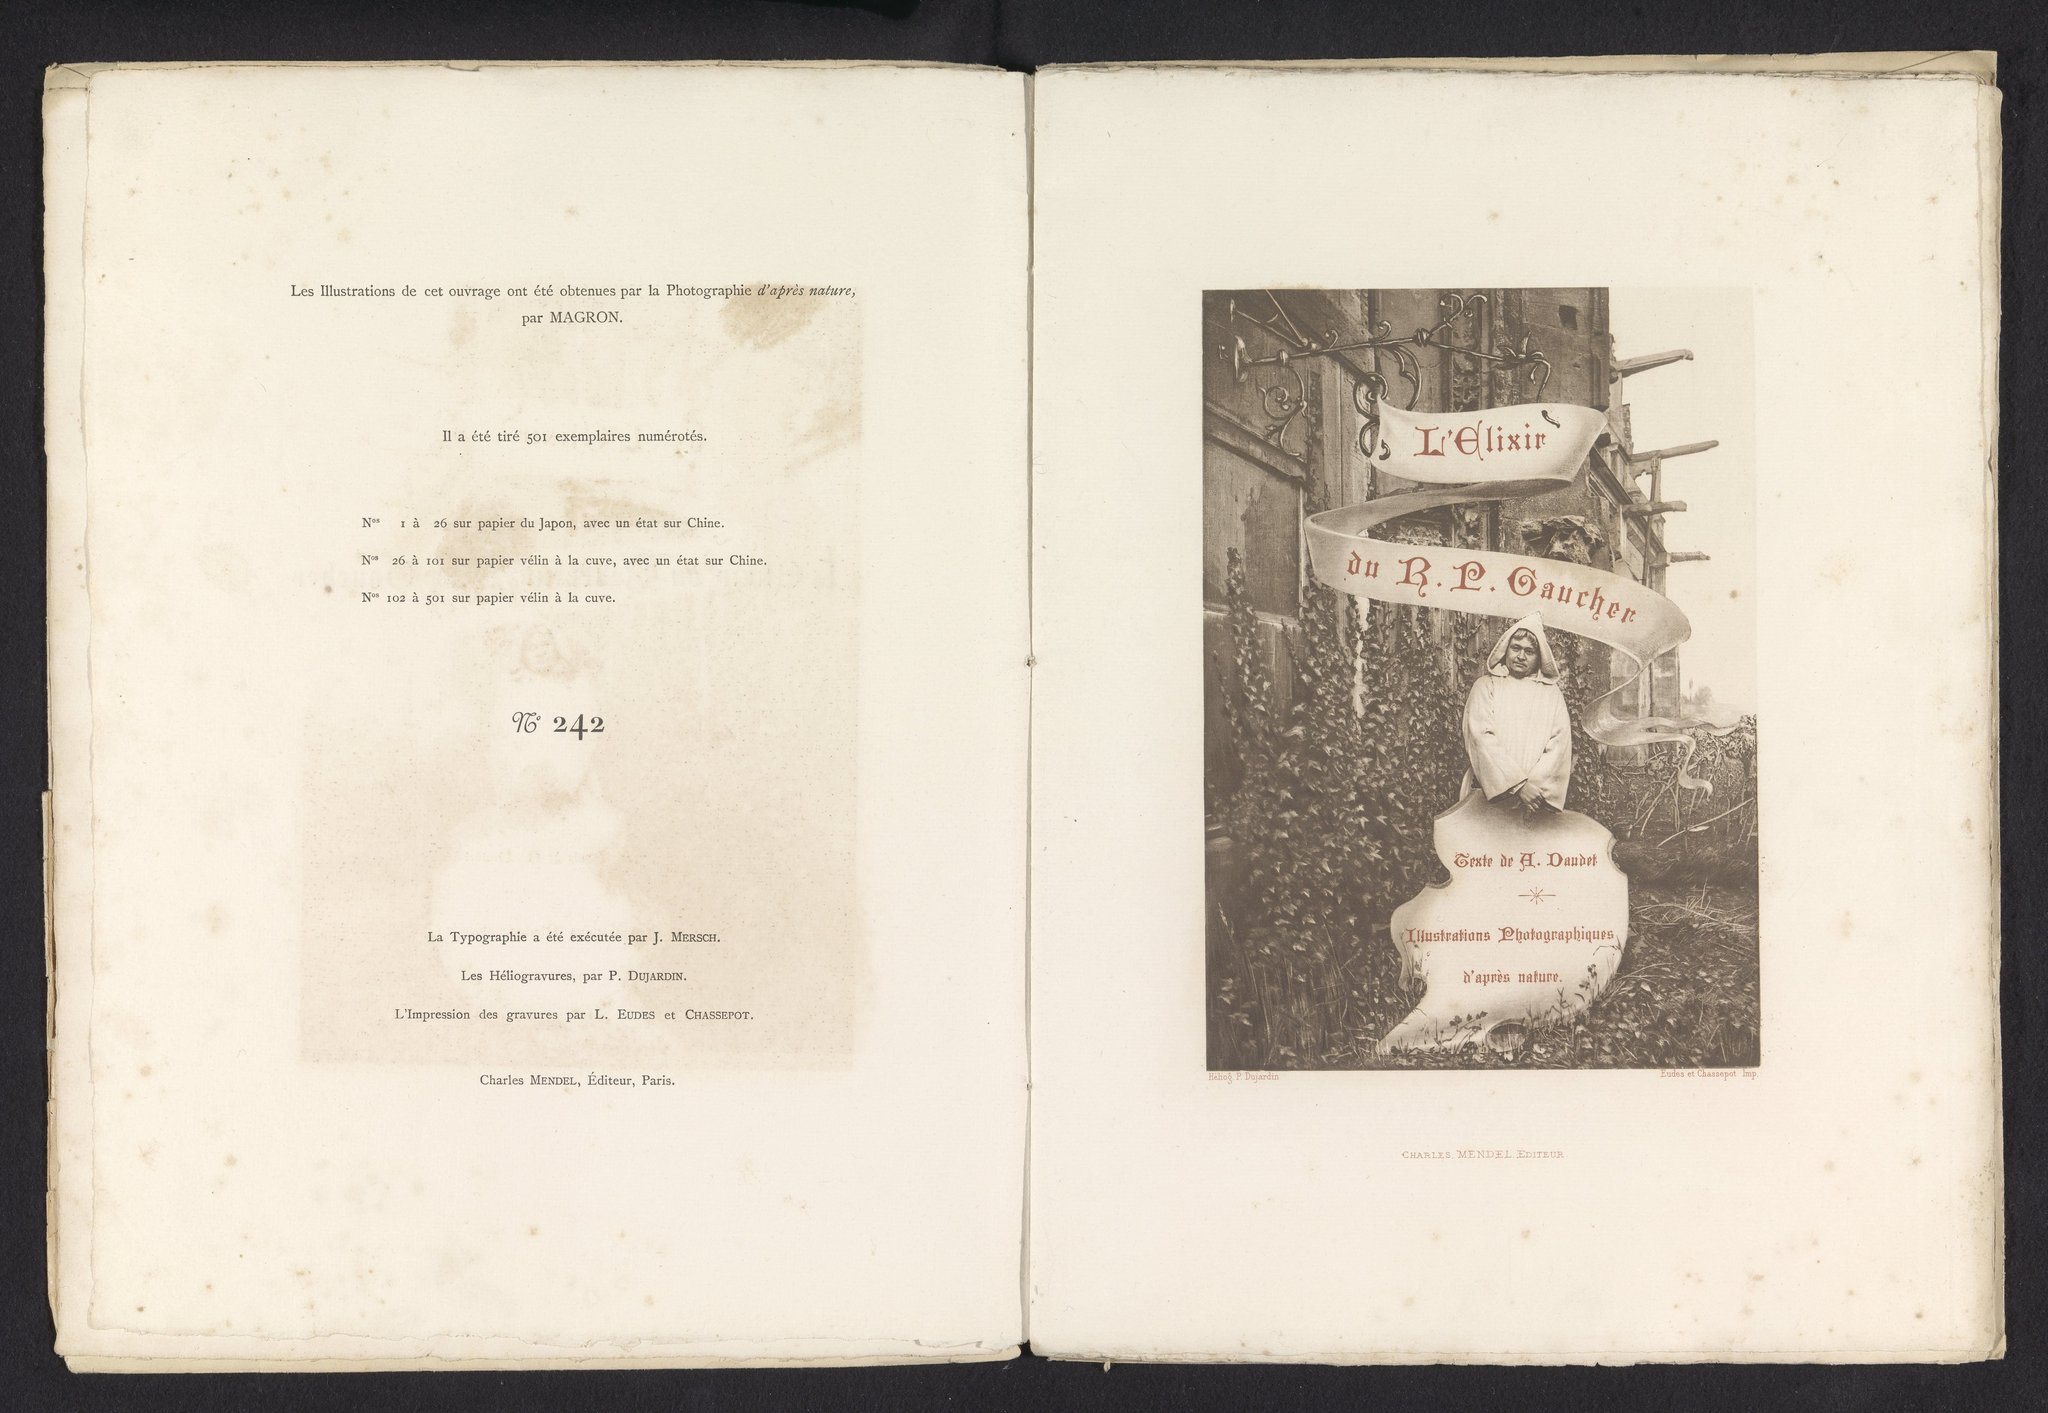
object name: photomechanical print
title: Monnik voor een kerk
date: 1885-1896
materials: paper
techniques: photoaquatint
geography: france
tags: church (exterior), monk(s), friar(s)